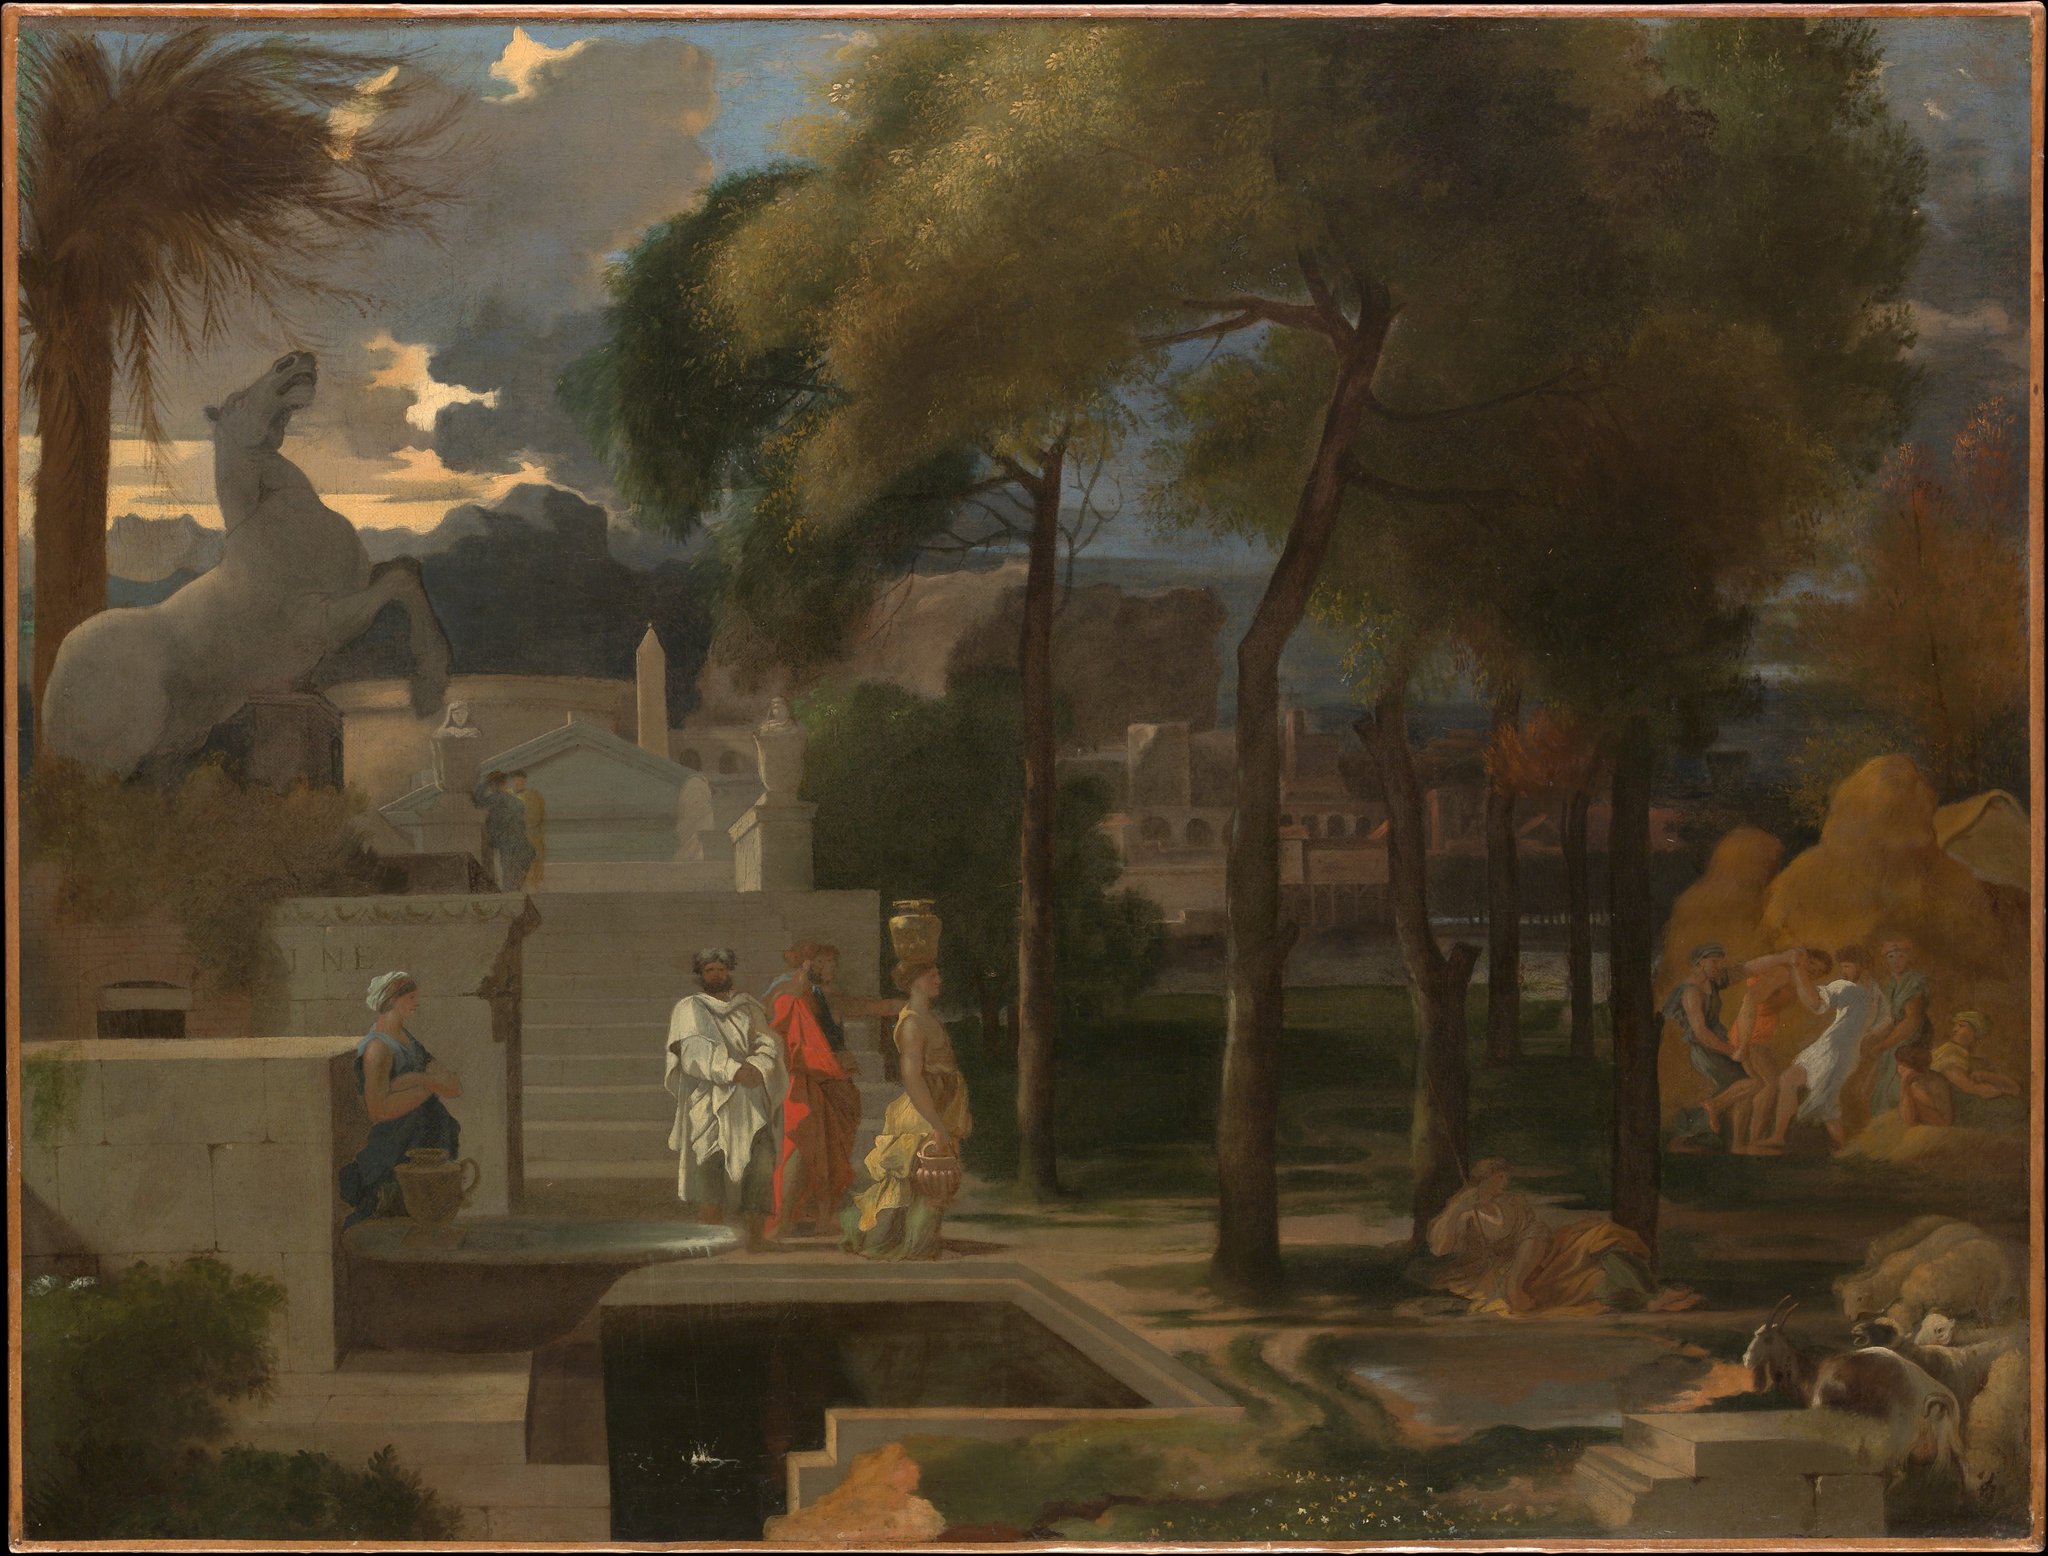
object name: painting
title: A Classical Landscape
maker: sébastien bourdon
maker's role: artist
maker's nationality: french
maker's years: 1616-1671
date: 1660-1669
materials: canvas, oil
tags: human figures,horses,landscapes